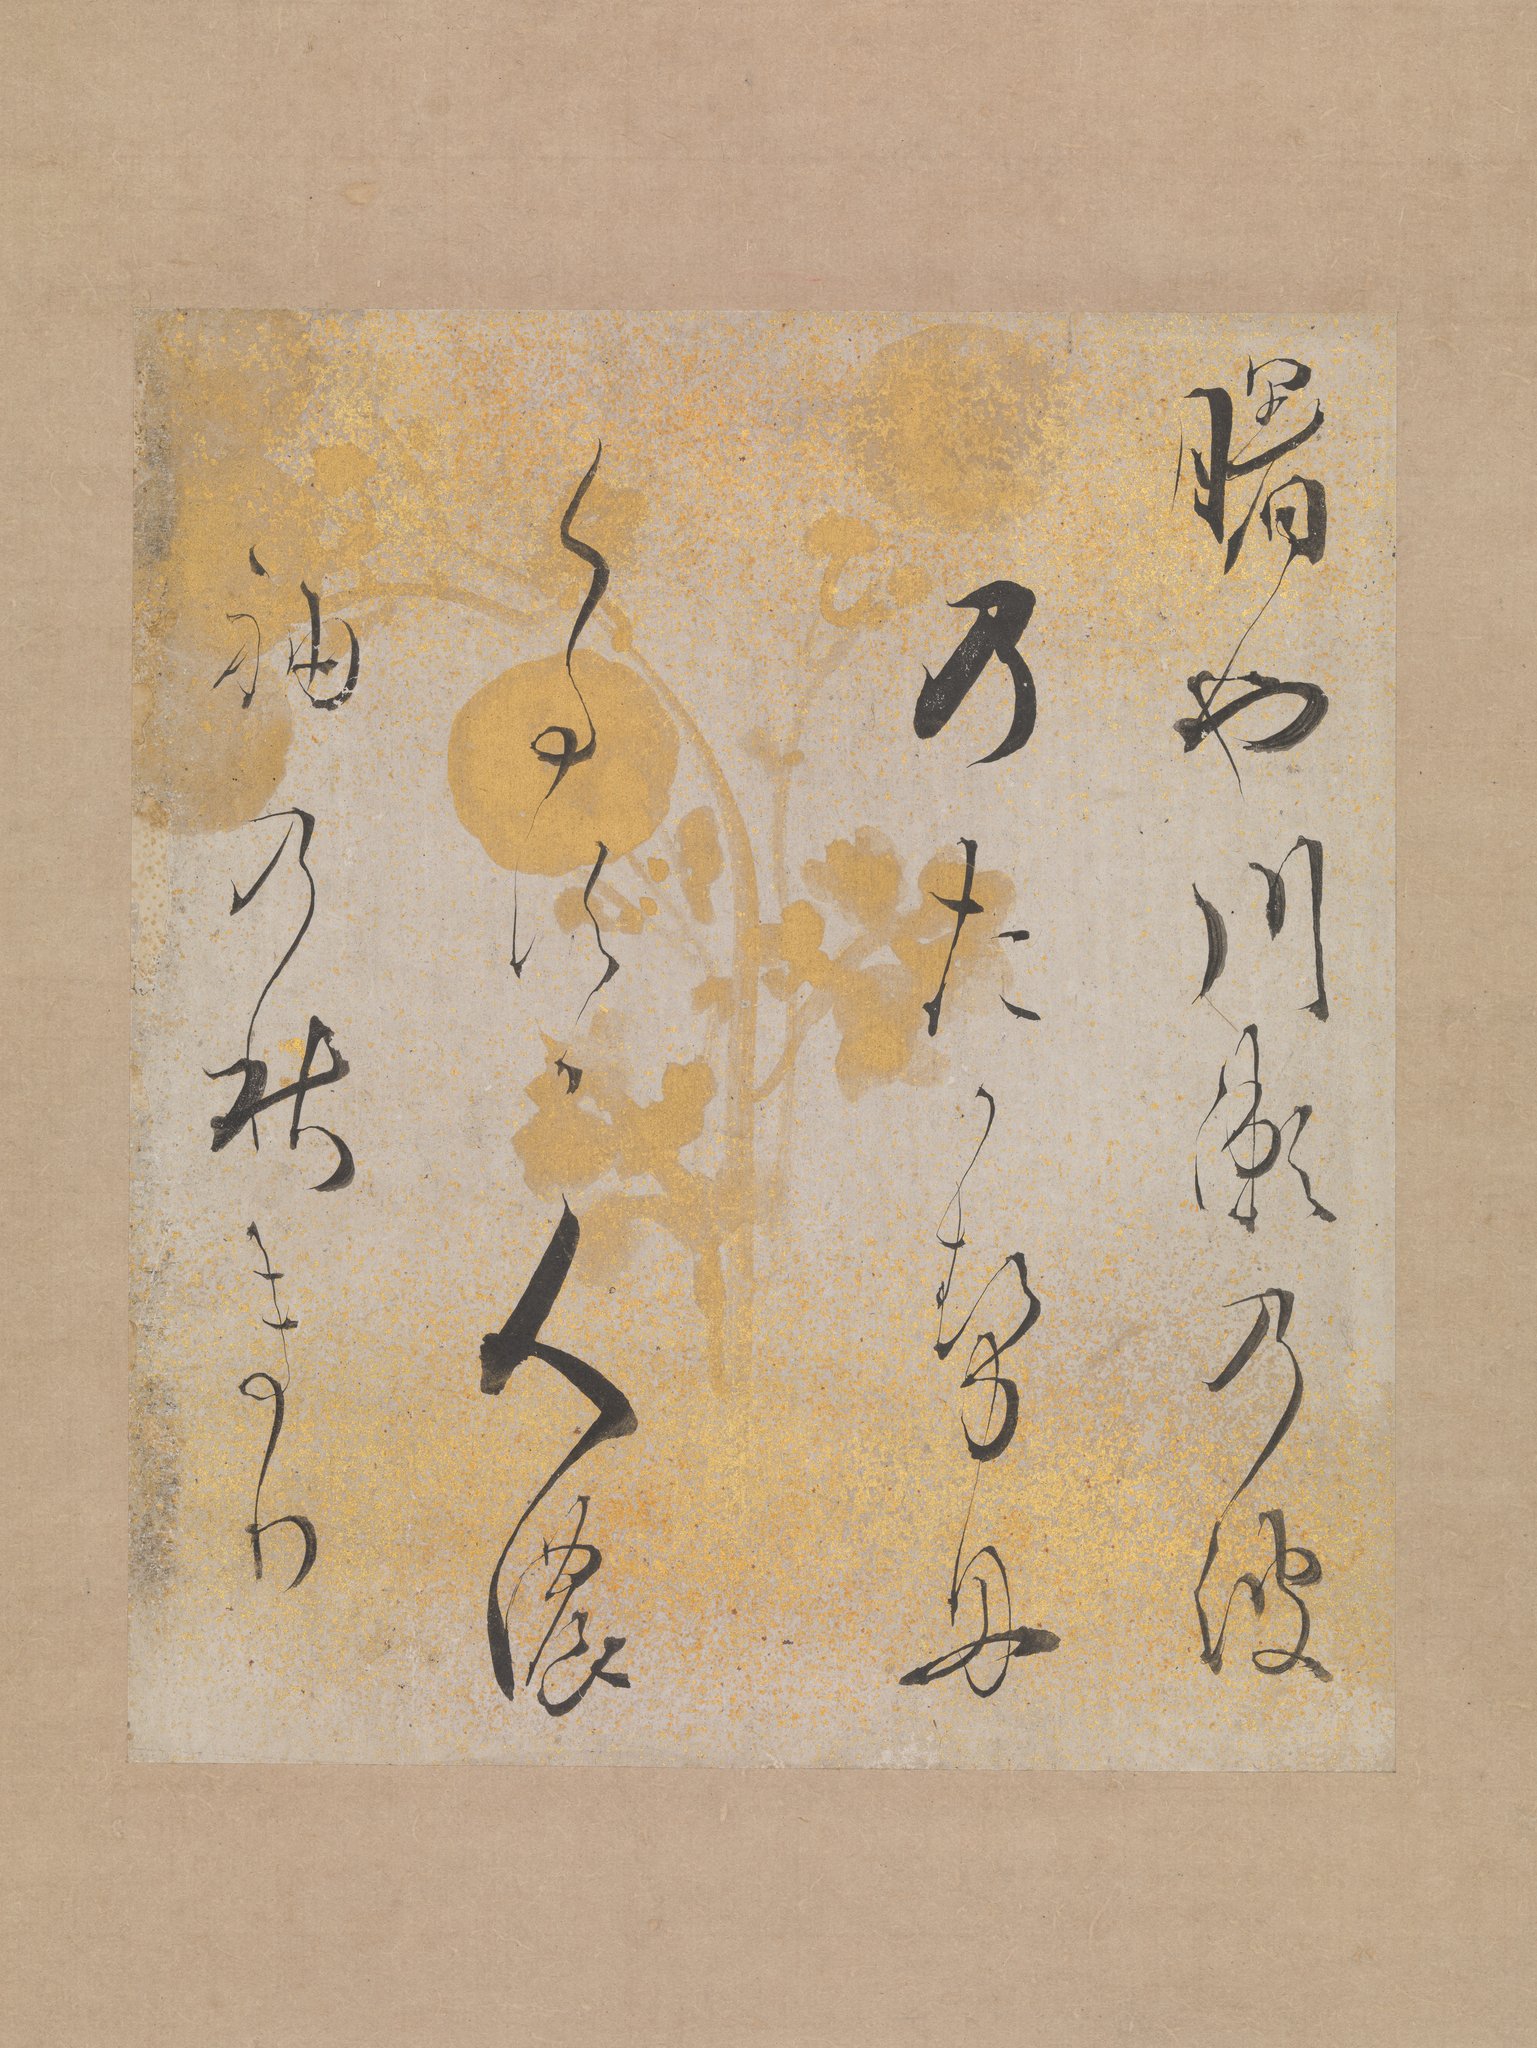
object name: hanging scroll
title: “Akebonoya” waka poem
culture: japanese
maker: hon'ami kōetsu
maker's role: artist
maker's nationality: japanese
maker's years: 1558-1637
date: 1601-1633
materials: gold, ink, paper